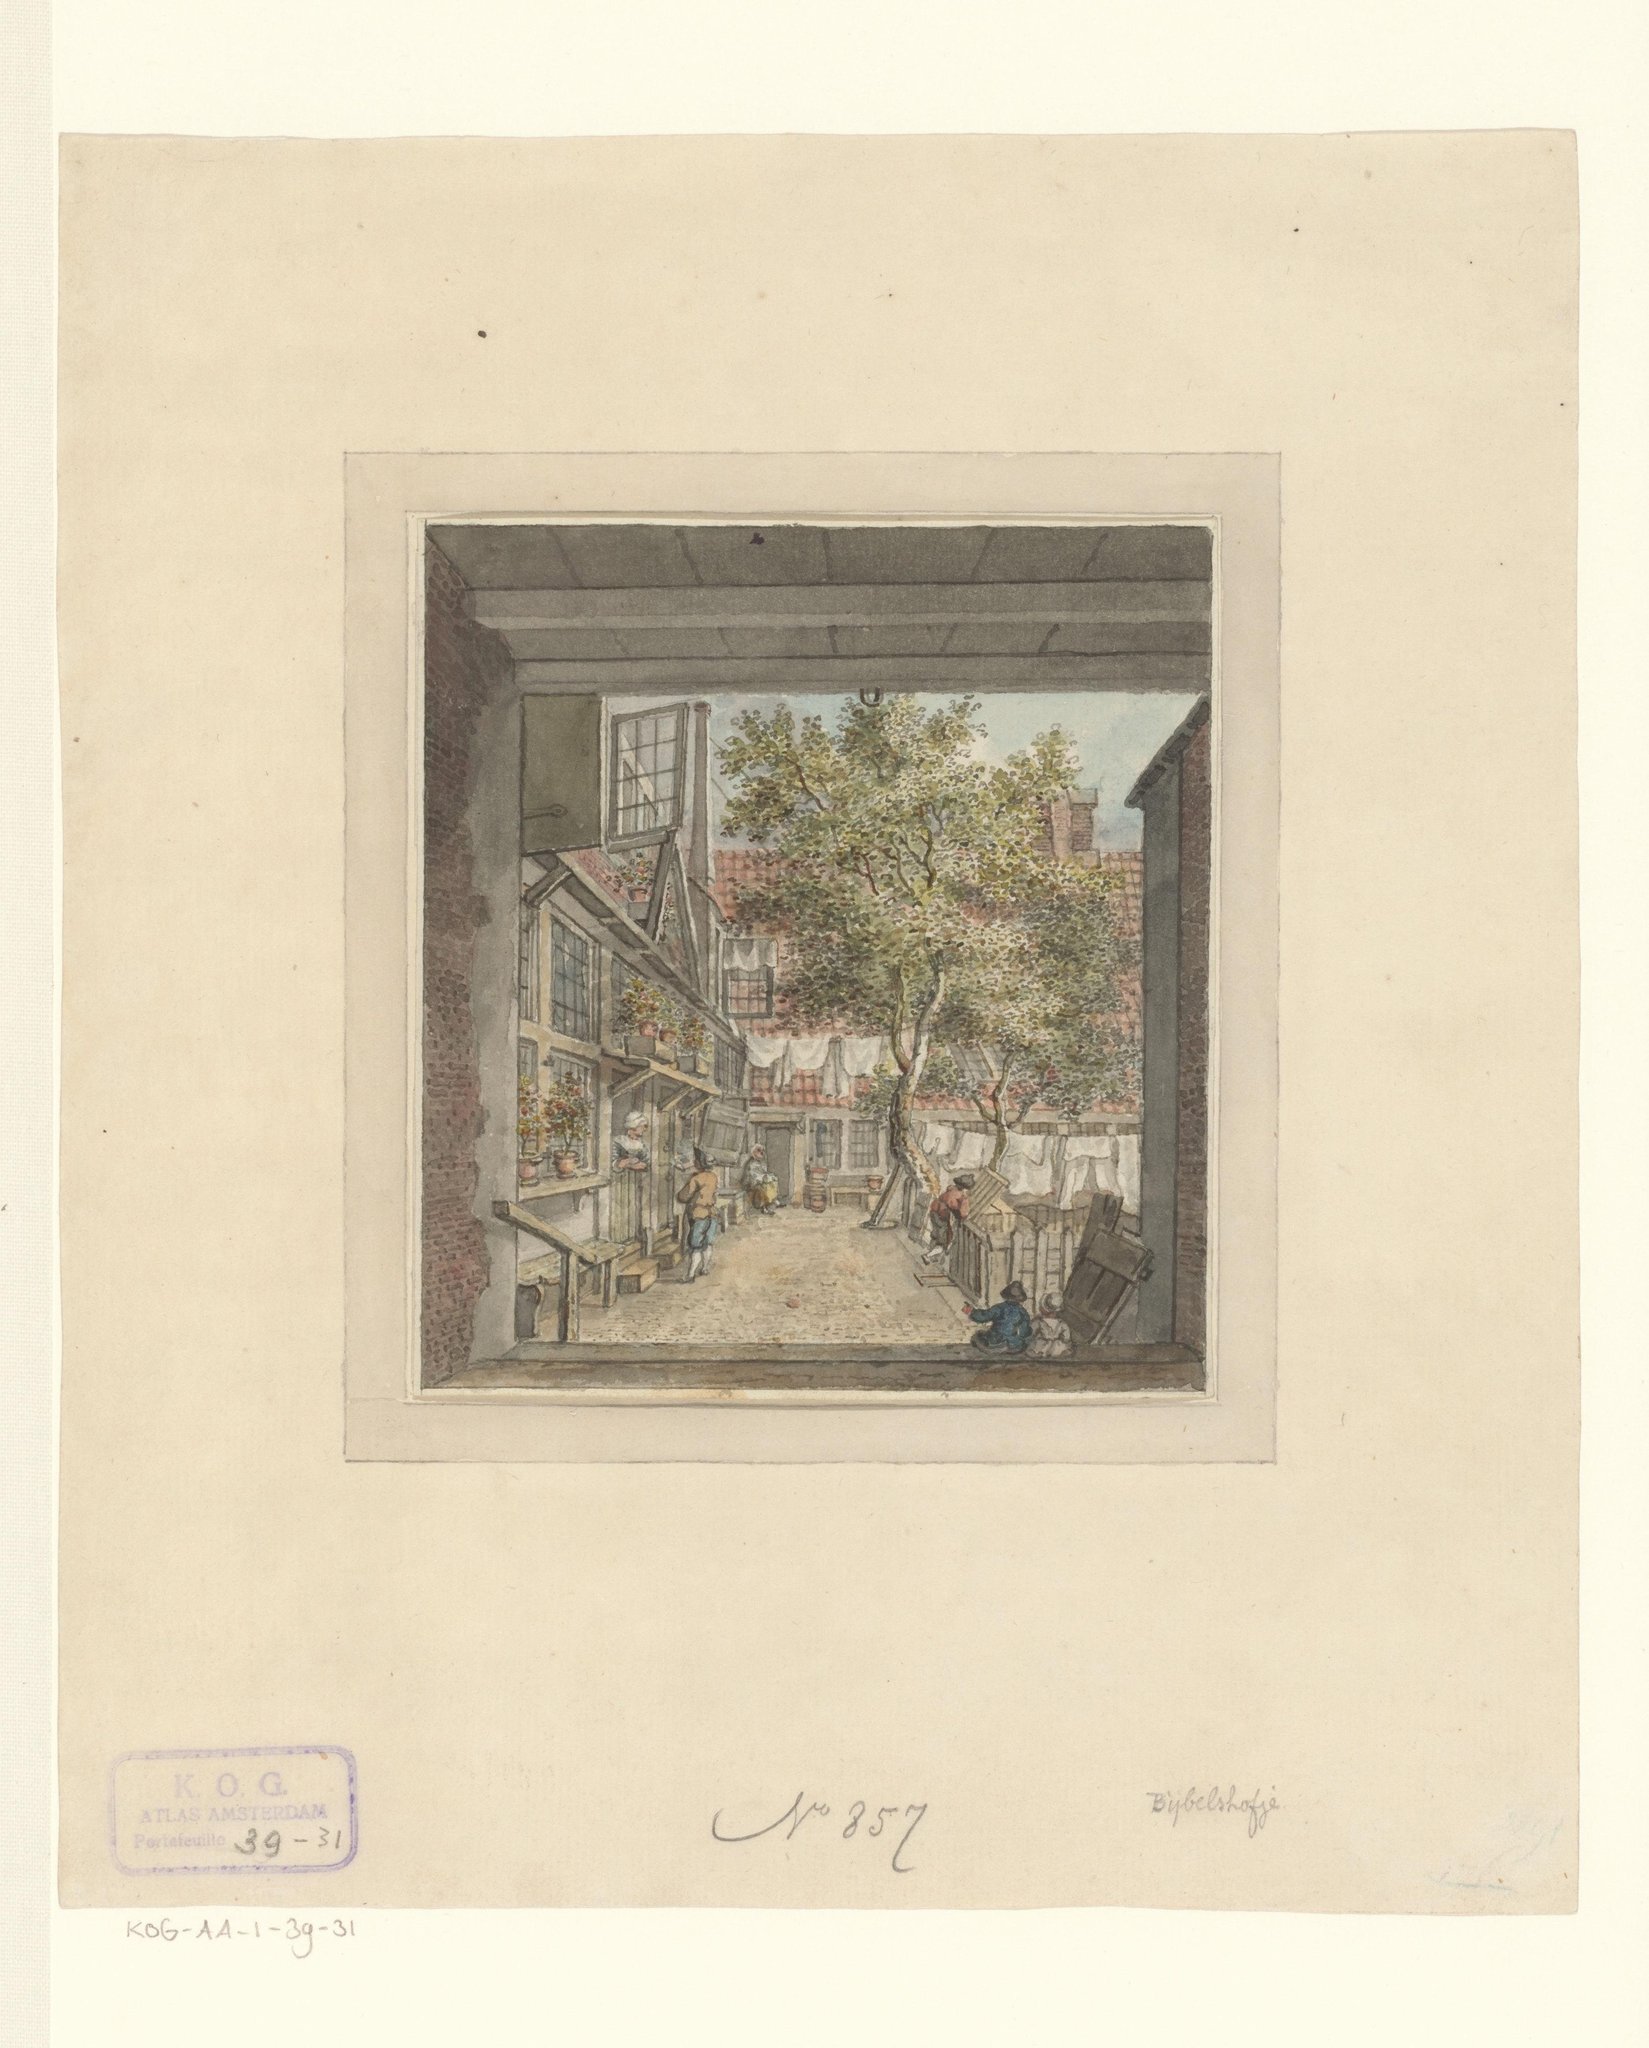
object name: drawing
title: Gezicht op het oude Bijbelshofje in de Anjelierstraat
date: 1700-1799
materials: ink, paper, pencil, watercolor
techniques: brush, pen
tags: alms-house (dutch: 'hofje'), city-view in general; 'veduta'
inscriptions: collector's mark: ‘39-31’ Lugt 1641b, inscription: ‘het oude bijbelshofje inde / angelierstraat tot amsterdam / No 45-55 1902’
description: Onderwerpsrubriek binnen de Atlas Amsterdam: Van Brienenhofje “de Star” - Bijbels Hofje - Claes Reyniershofje - Constantiahofje.